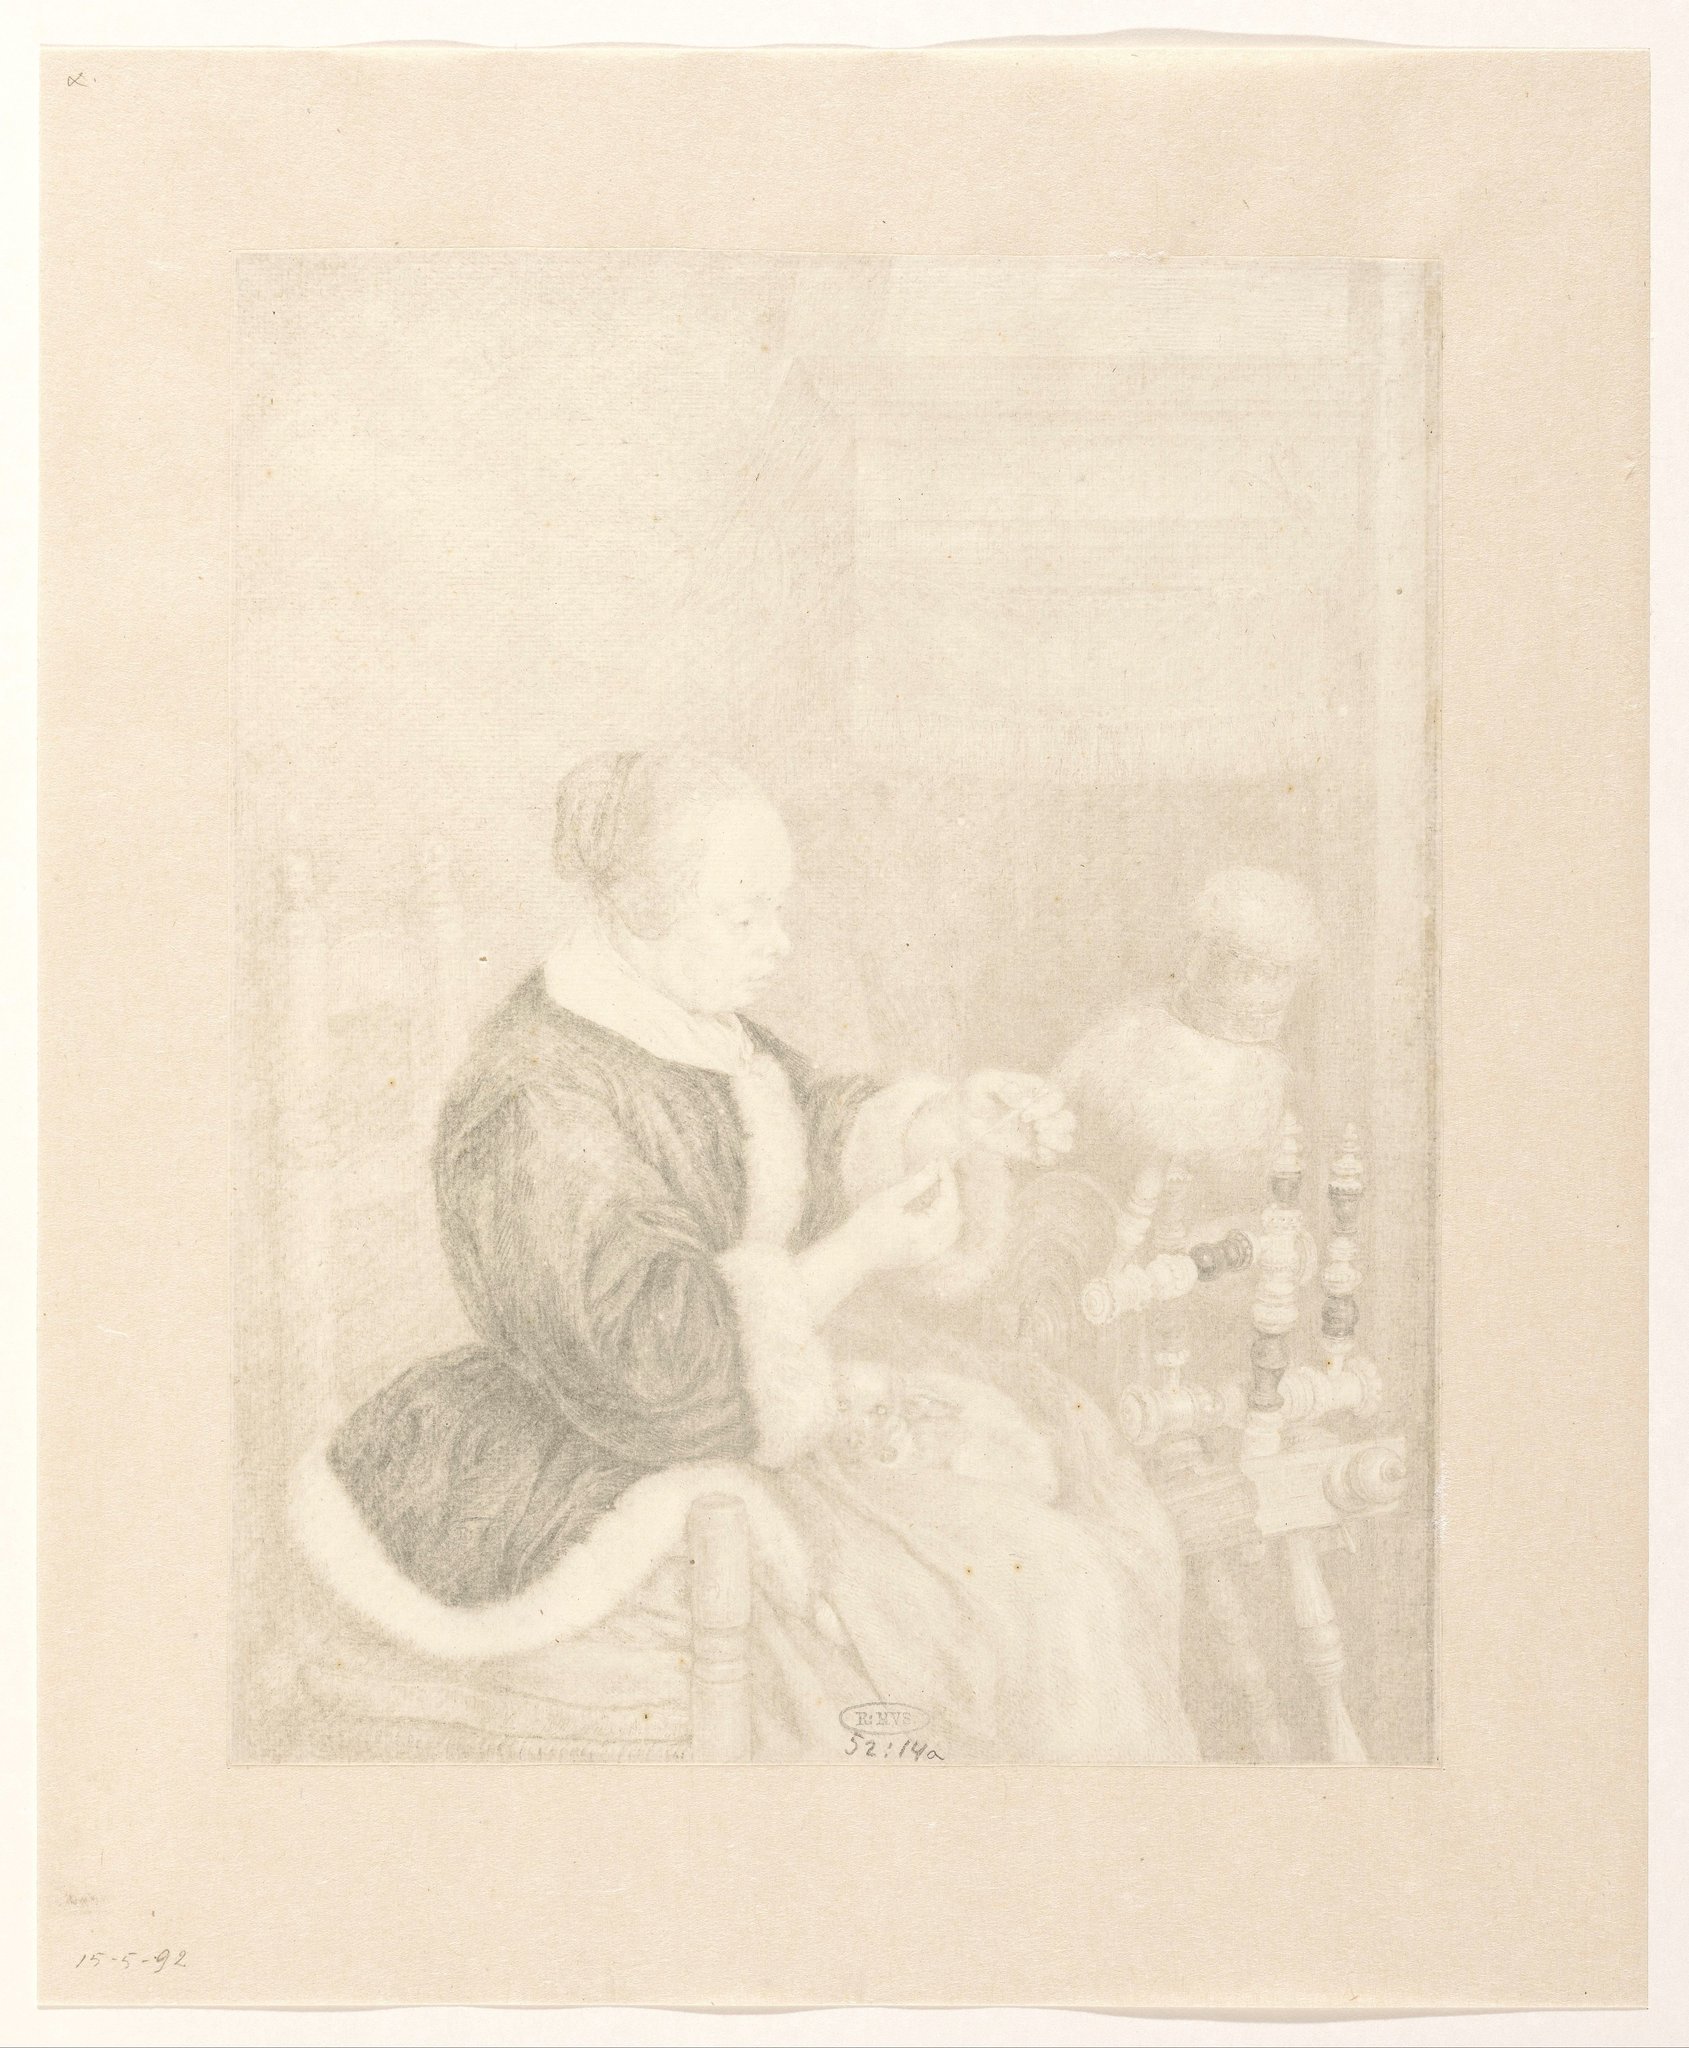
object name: drawing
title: De Spinster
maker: abraham delfos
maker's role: draughtsman, painter, print maker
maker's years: 1731-1820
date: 1741-1820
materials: chalk, paper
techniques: printmaking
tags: spinning (manufacture of yarn)